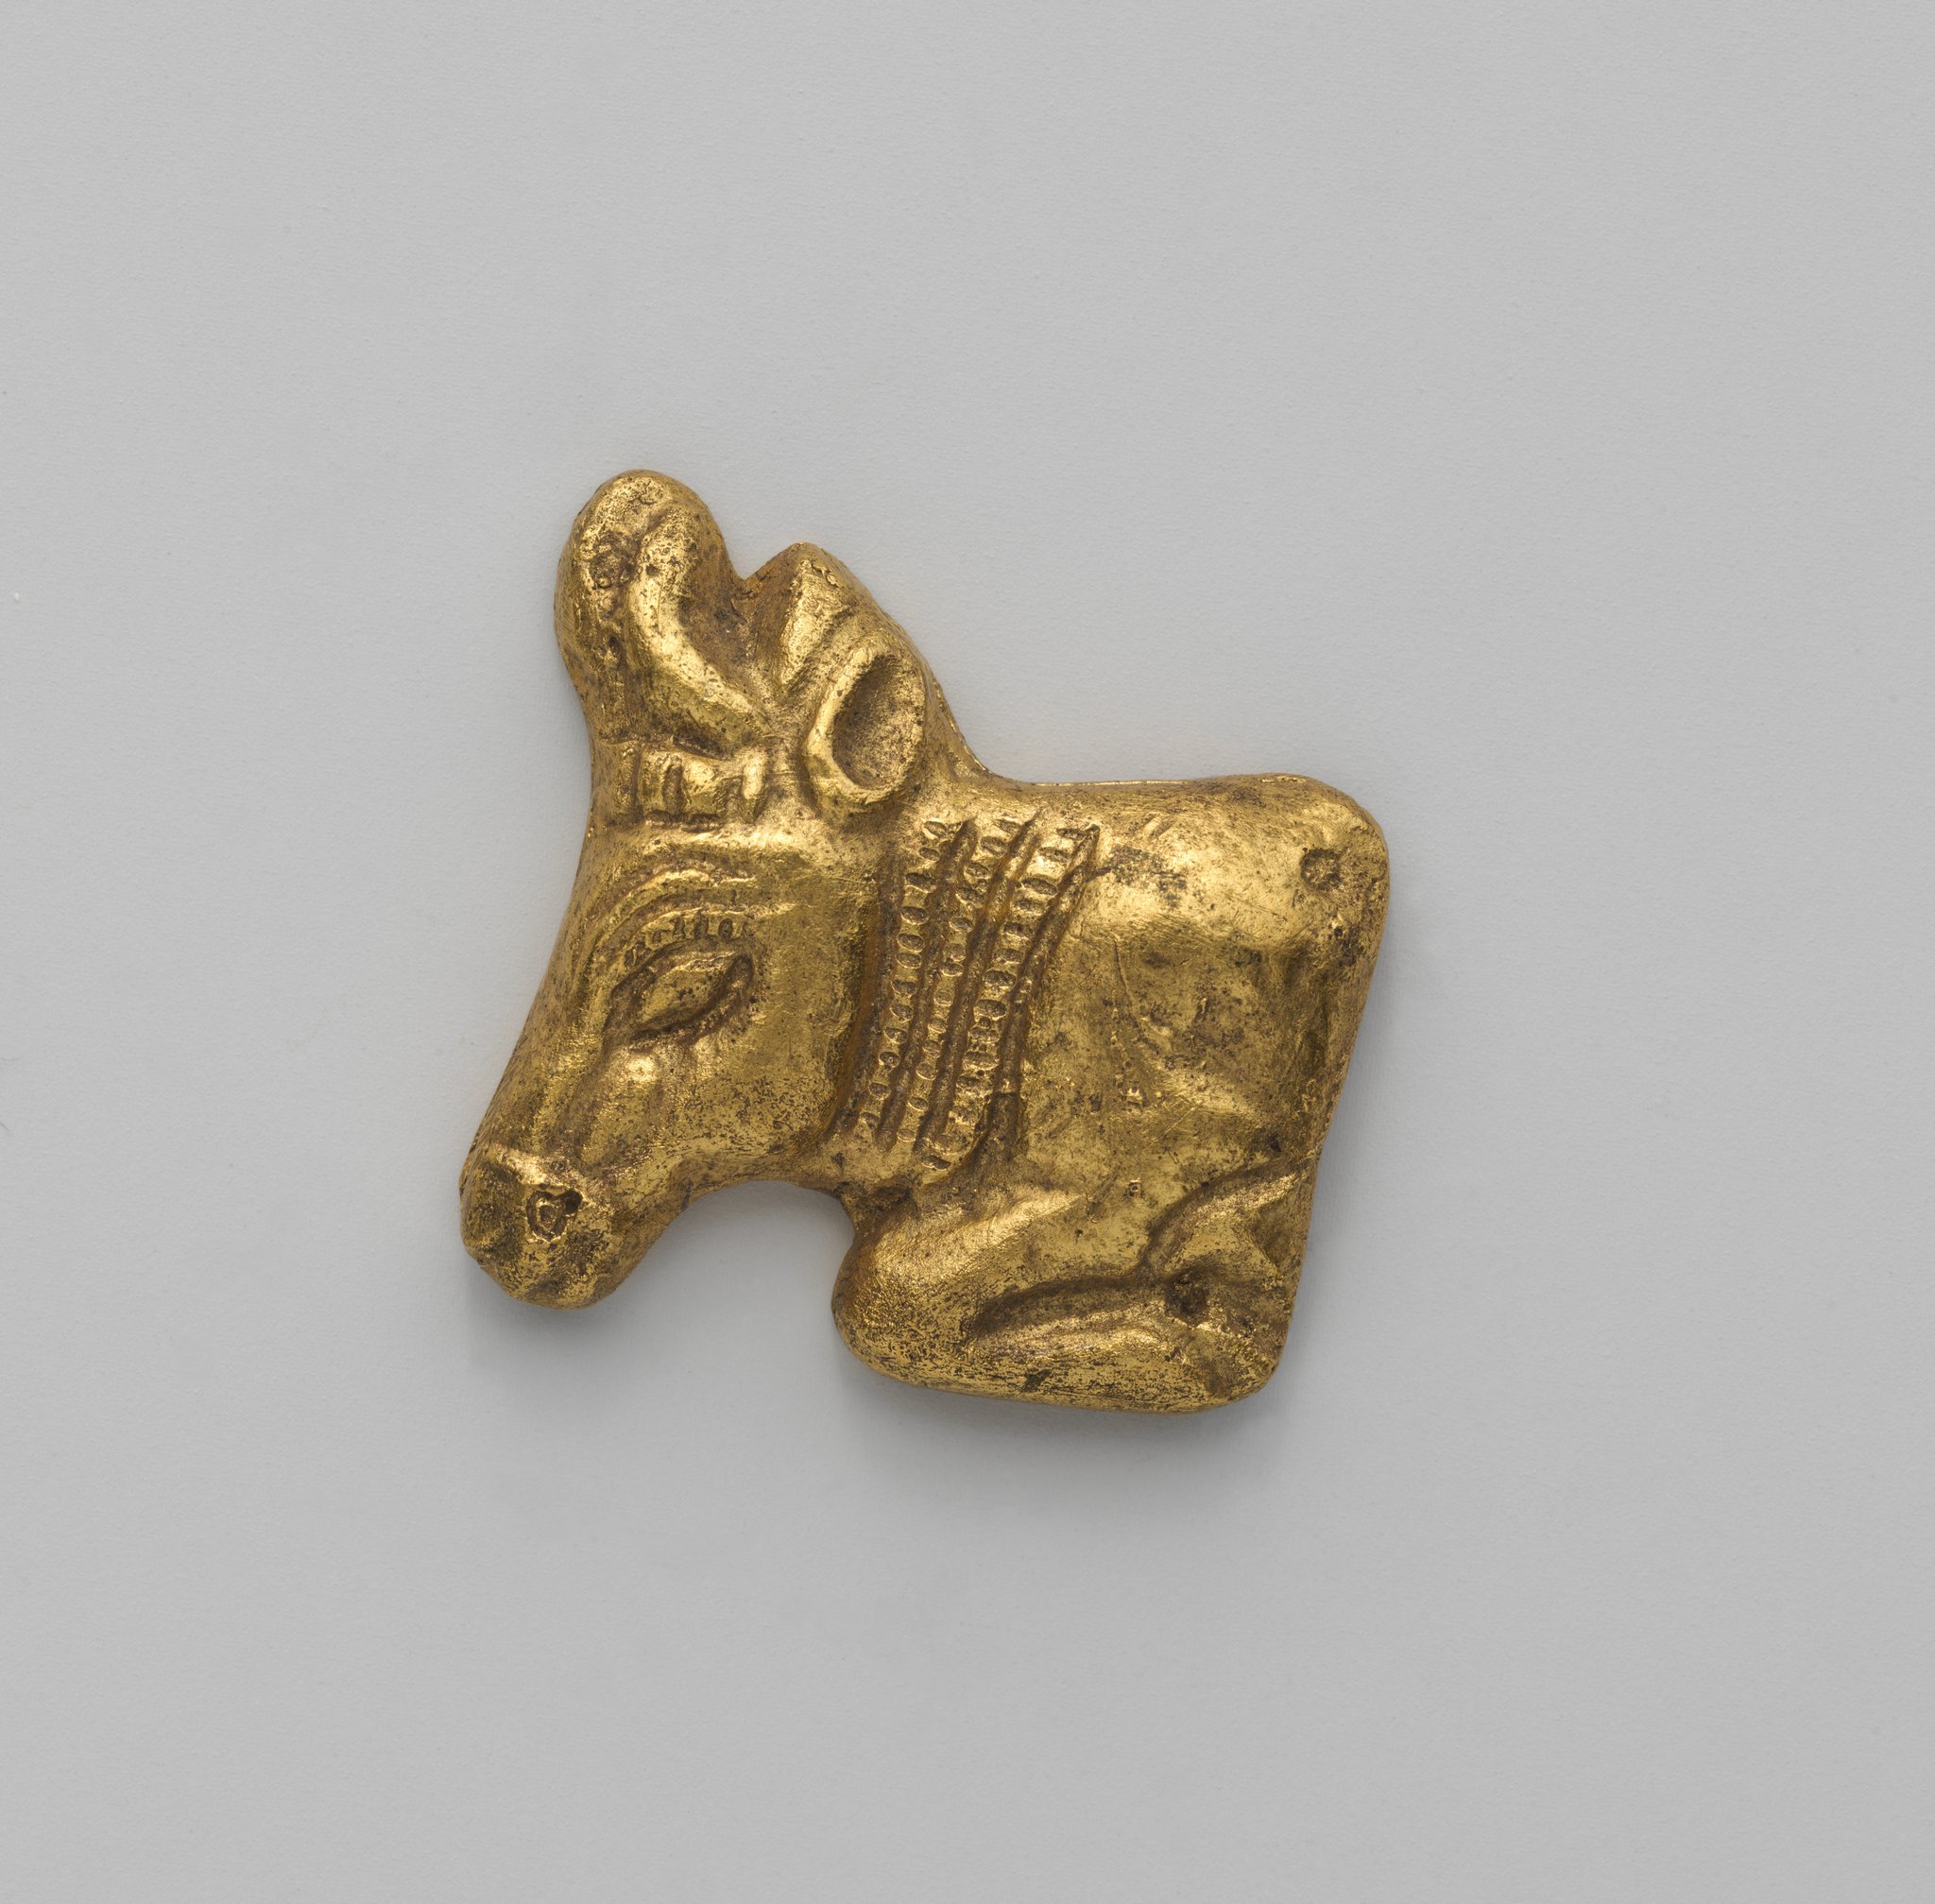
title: Reproduction of a Scythian plaque in the form of a cow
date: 1801-1900